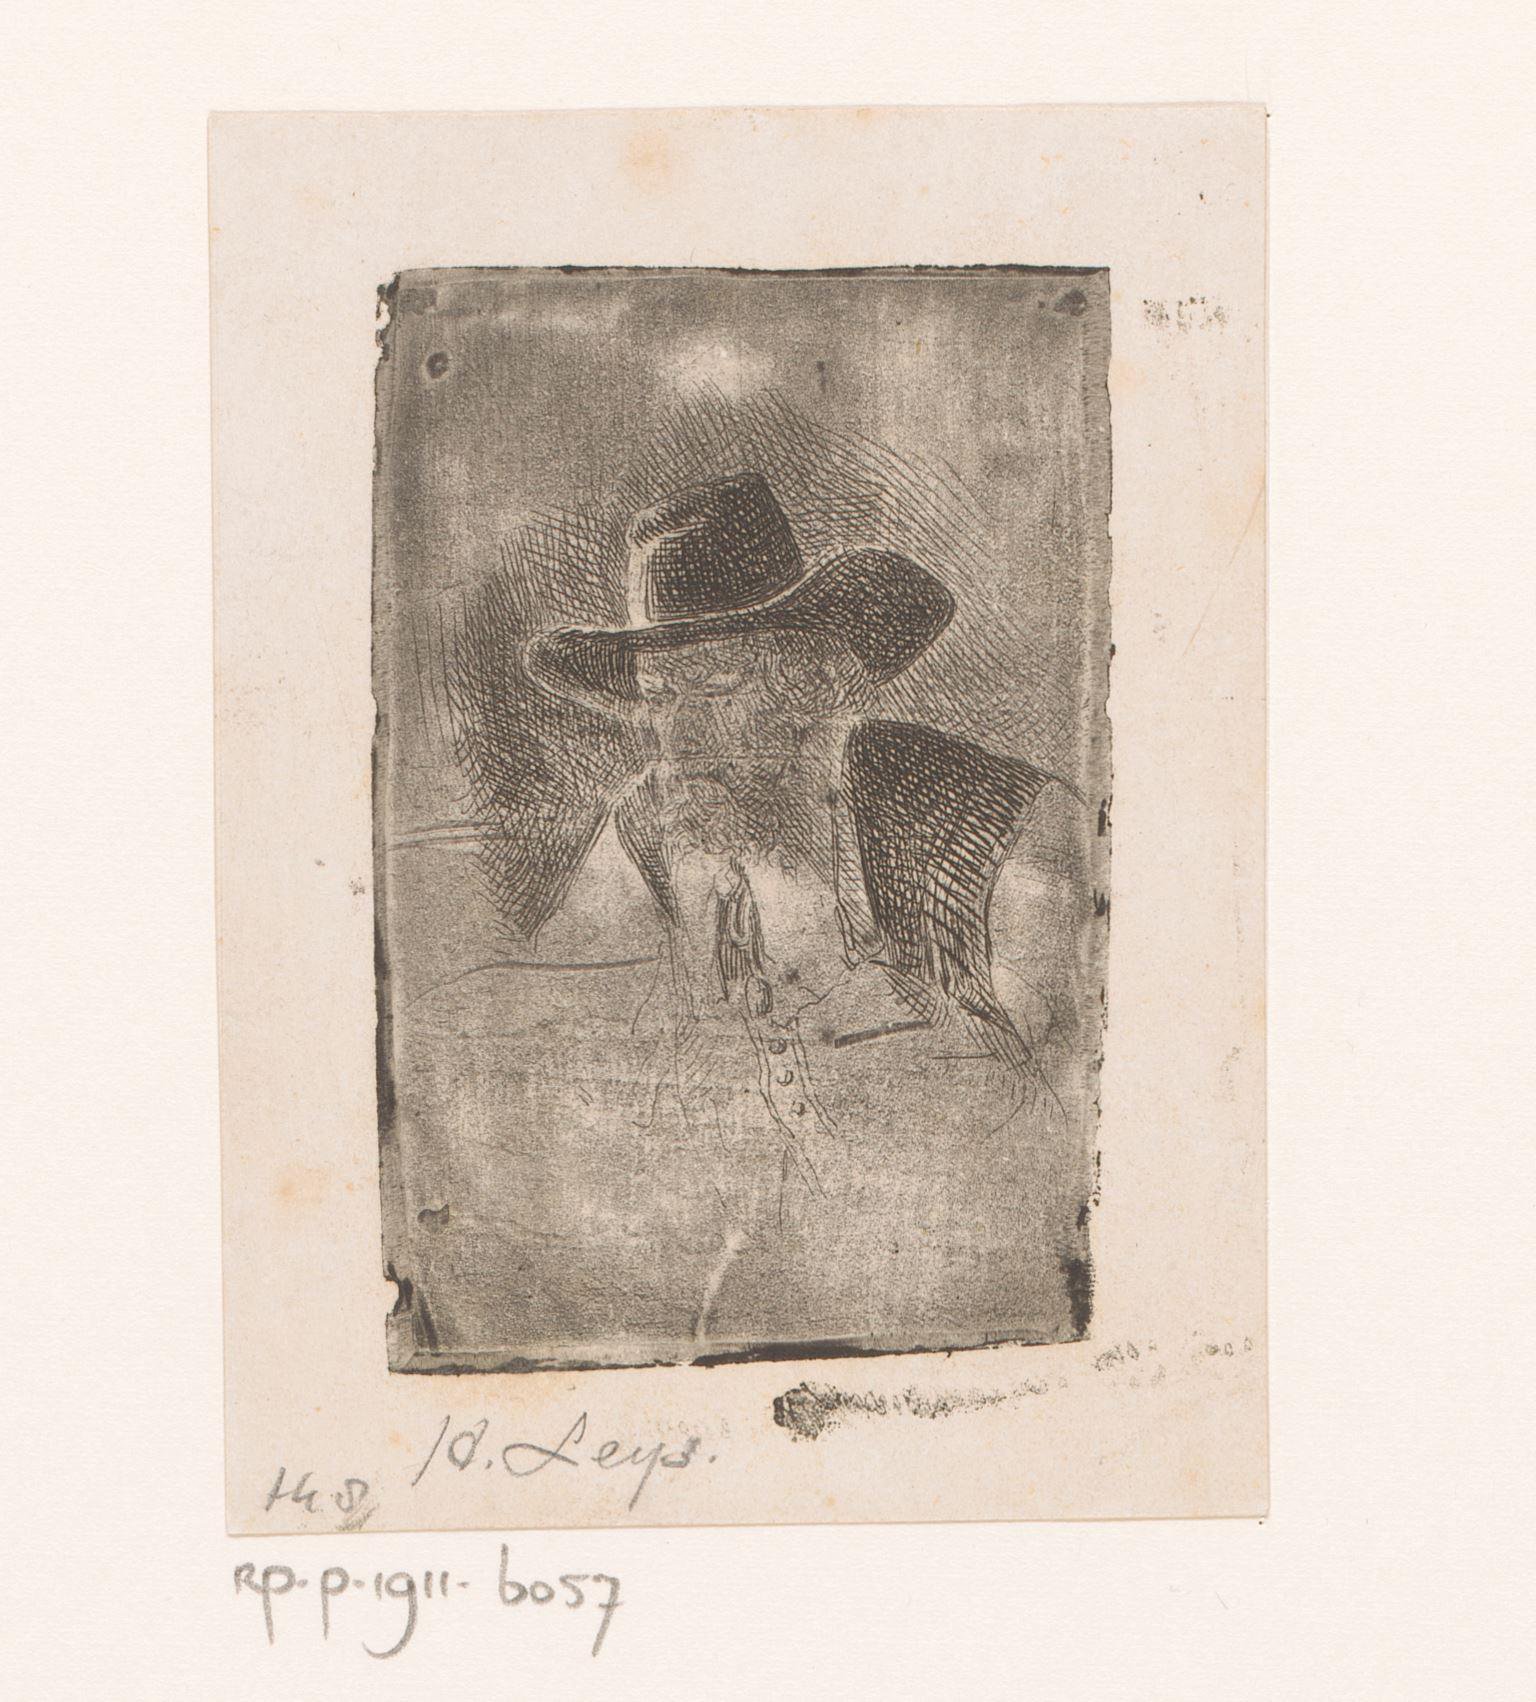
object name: print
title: Portret van een onbekende oude man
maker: henri leys (baron)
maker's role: draughtsman, painter, print maker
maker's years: 1815-1869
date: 1825-1869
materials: paper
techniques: etching, intaglio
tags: old man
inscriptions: collector's mark: Lugt 1485, collector's mark: Lugt 2228